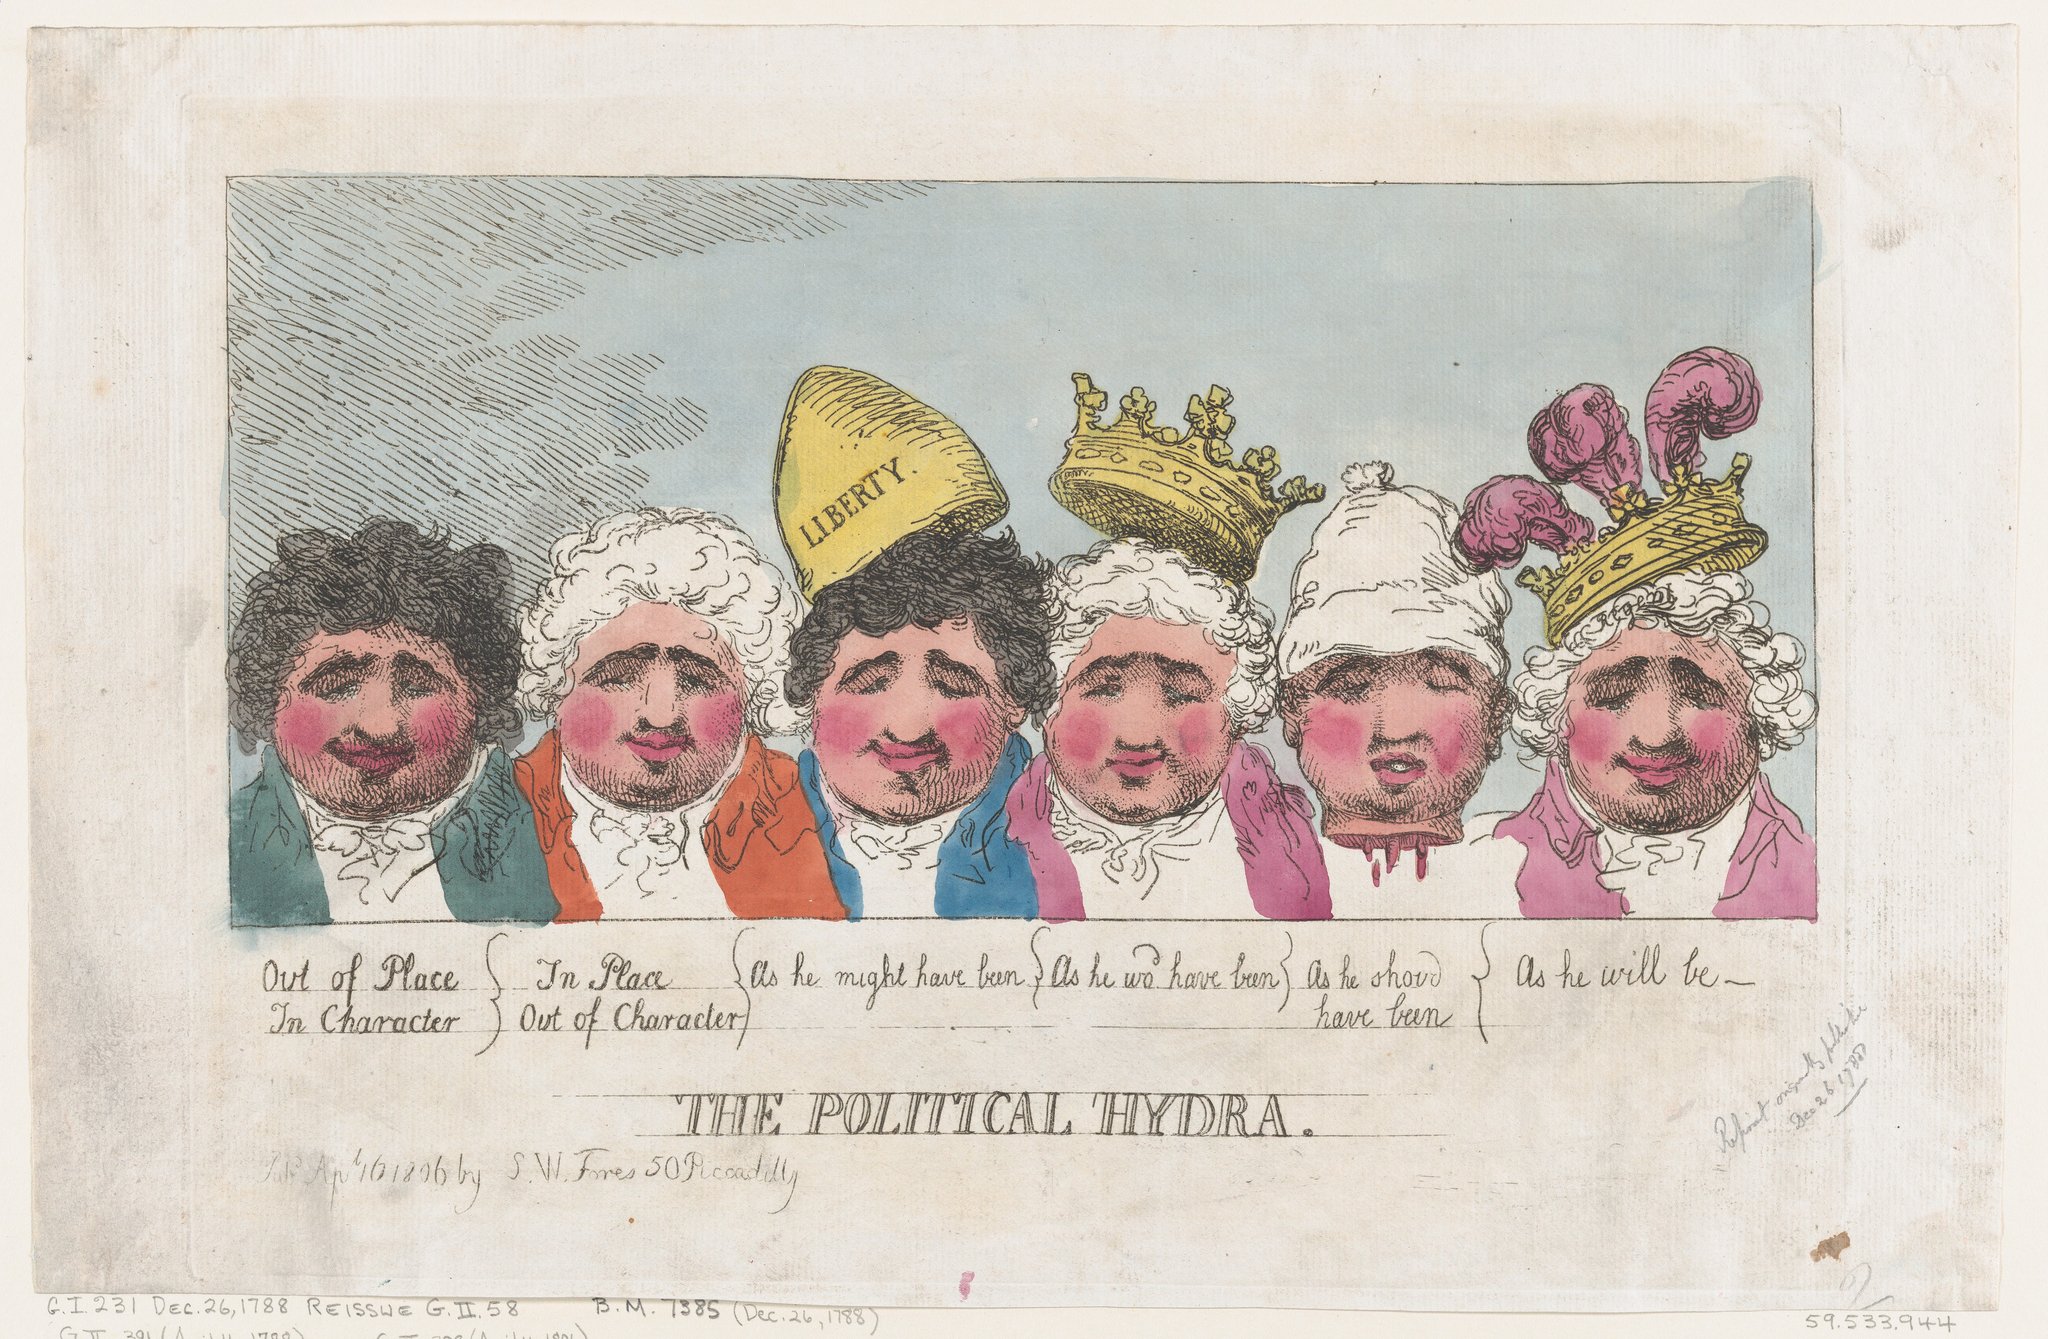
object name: print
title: The Politcal Hydra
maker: thomas rowlandson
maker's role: artist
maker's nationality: british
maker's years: 1757-1827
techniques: etching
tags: satire,men,politics